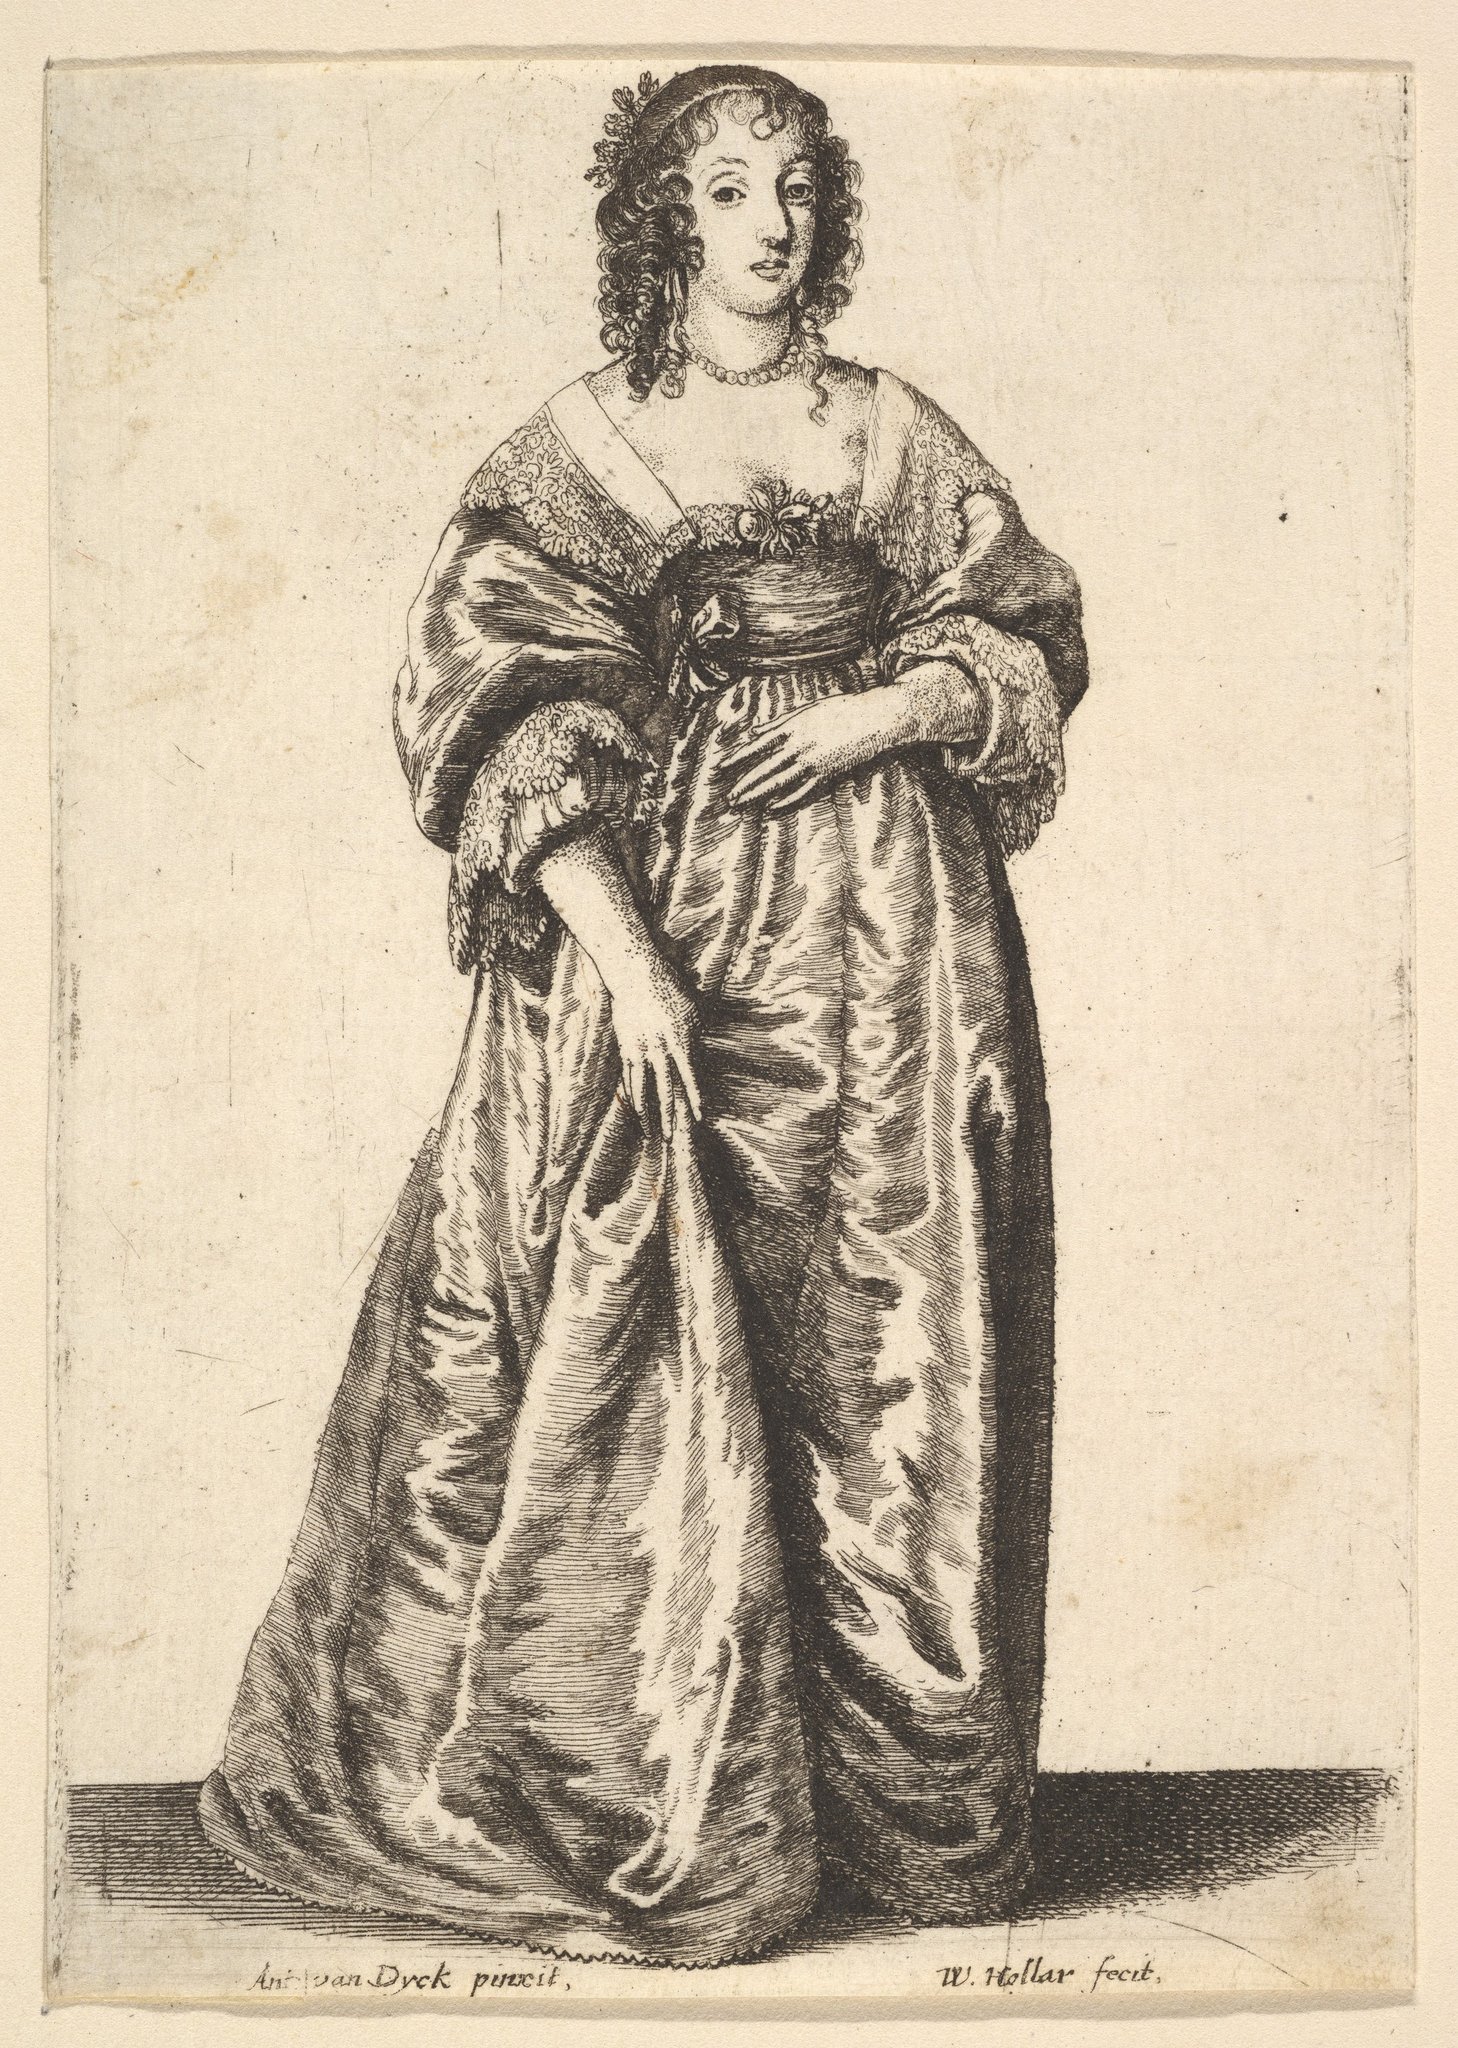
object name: print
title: Figure of a Lady Standing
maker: wenceslaus hollar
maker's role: artist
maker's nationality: bohemian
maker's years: 1607-1677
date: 1625-1677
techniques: etching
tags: portraits,women